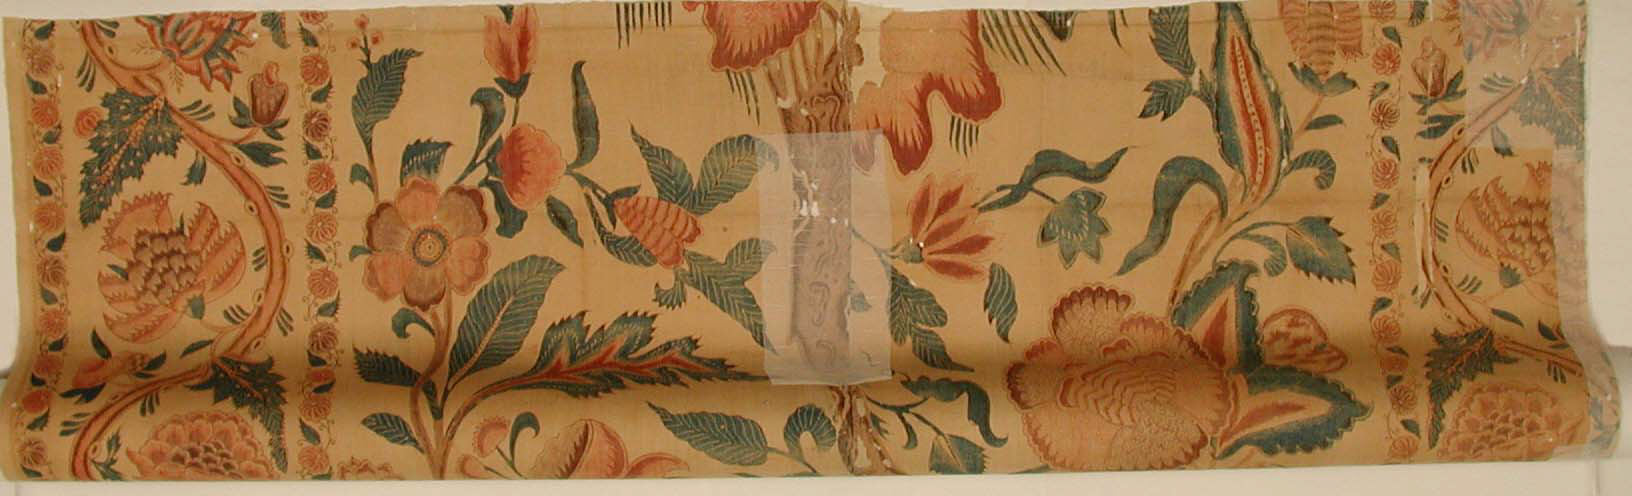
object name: hanging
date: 1601-1700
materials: cotton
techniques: printing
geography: india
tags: flowers,leaves